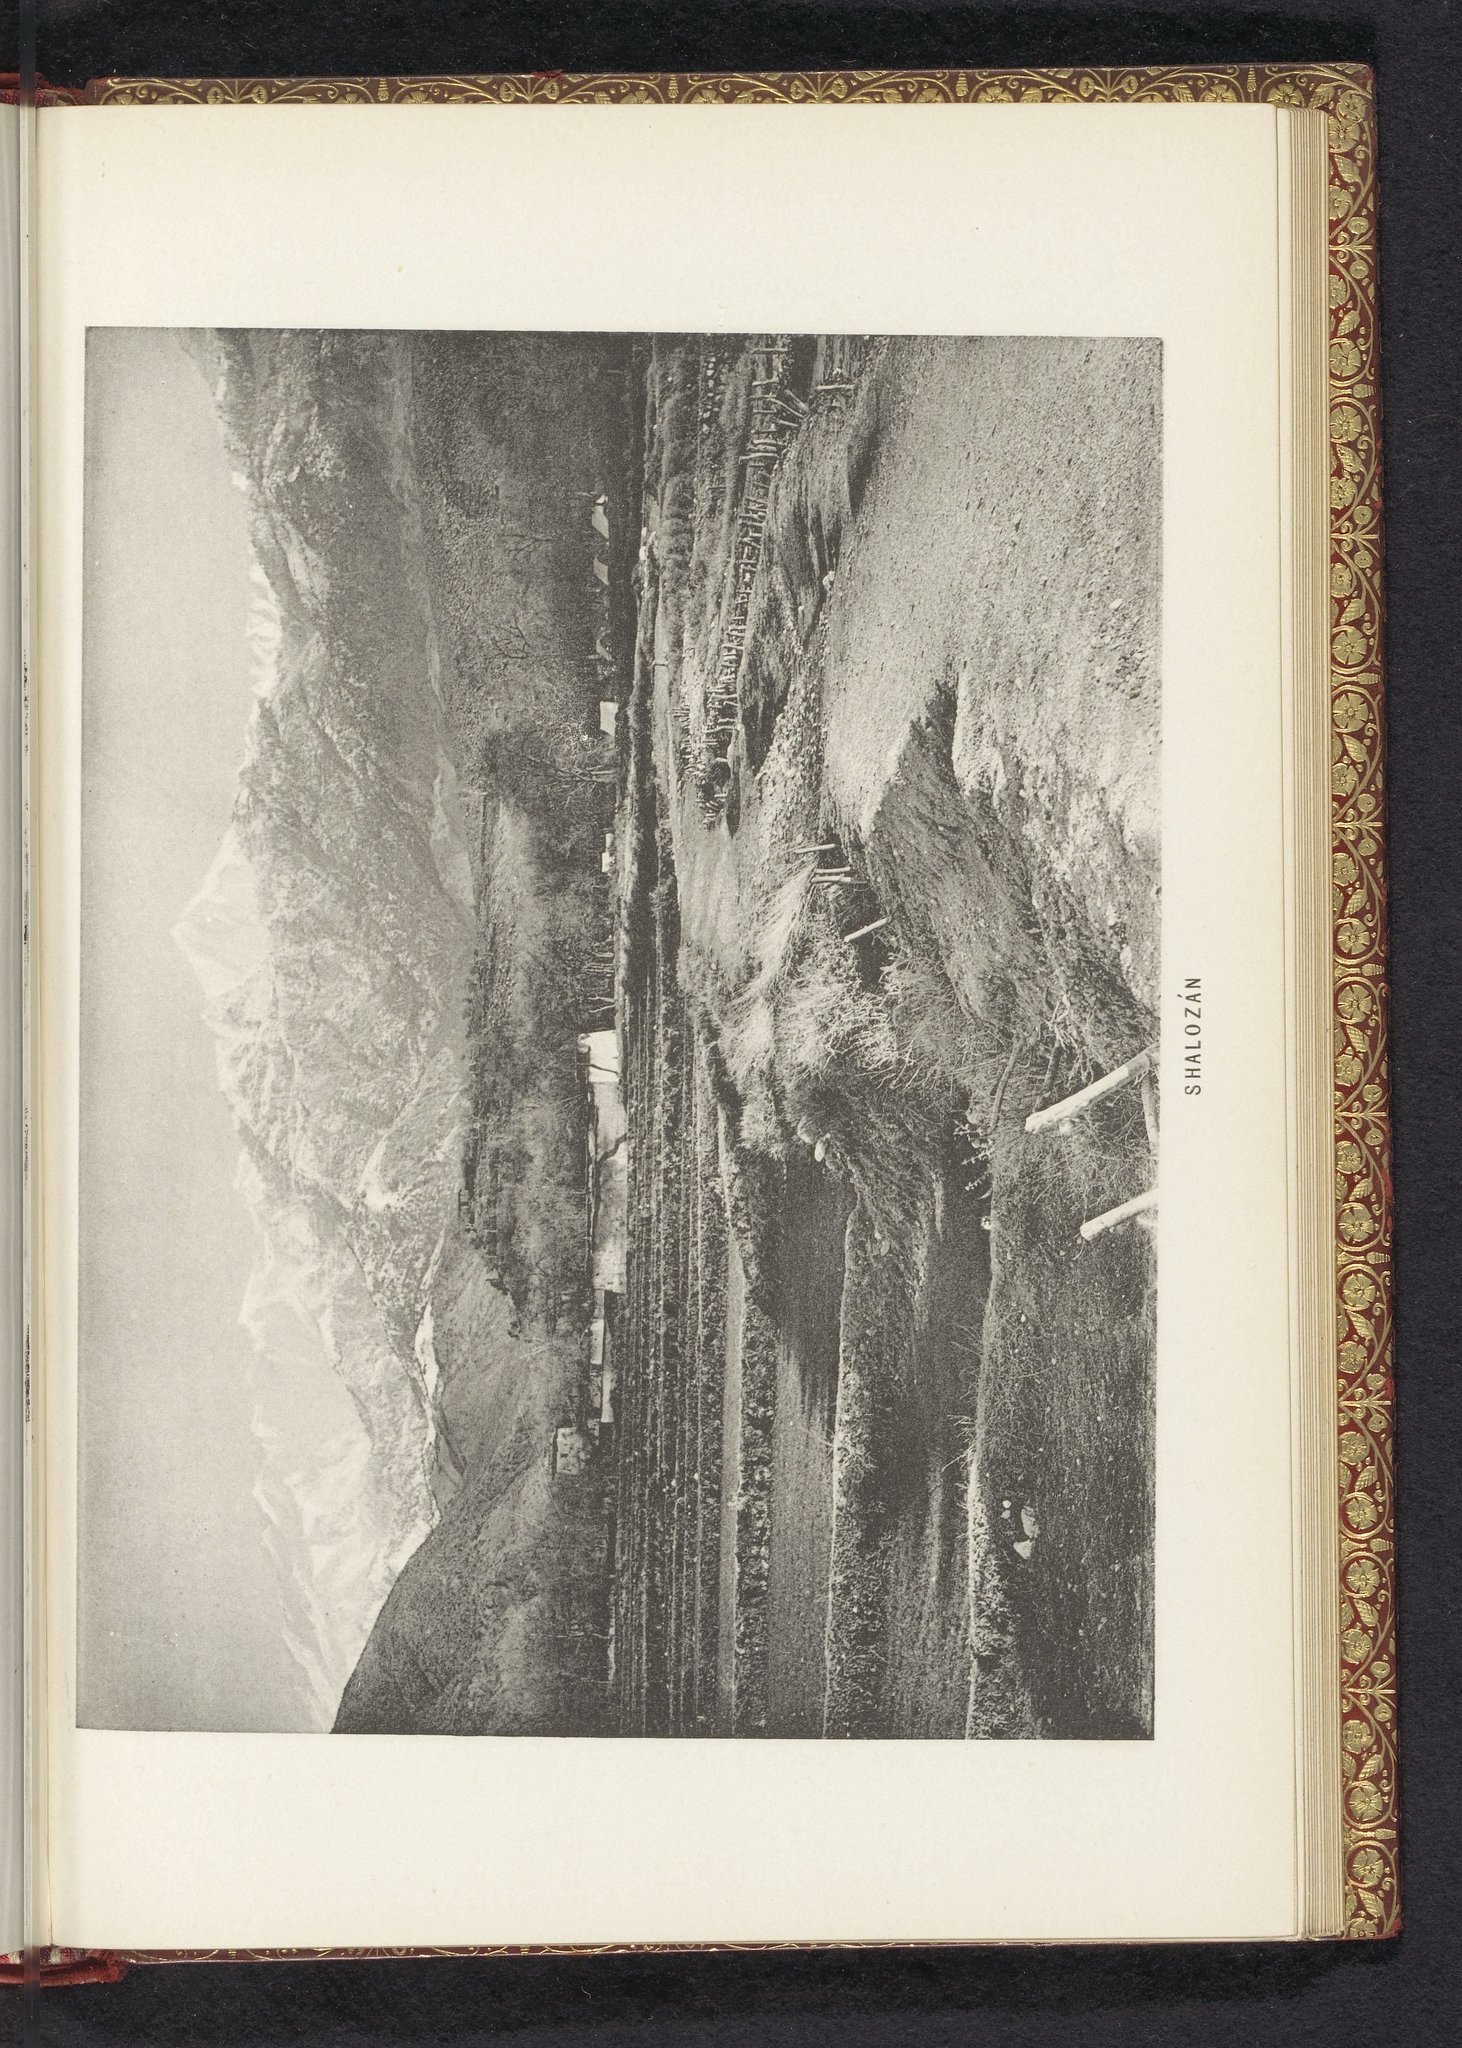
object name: photomechanical print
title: View of Shalozan in the Kurram Valley, Khyber Pakhtunkhwa, Pakistan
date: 1890-1895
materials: paper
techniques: photograph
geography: shalozan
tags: city-view in general; 'veduta', mountains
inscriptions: caption: ‘SHAHLOZÁN’